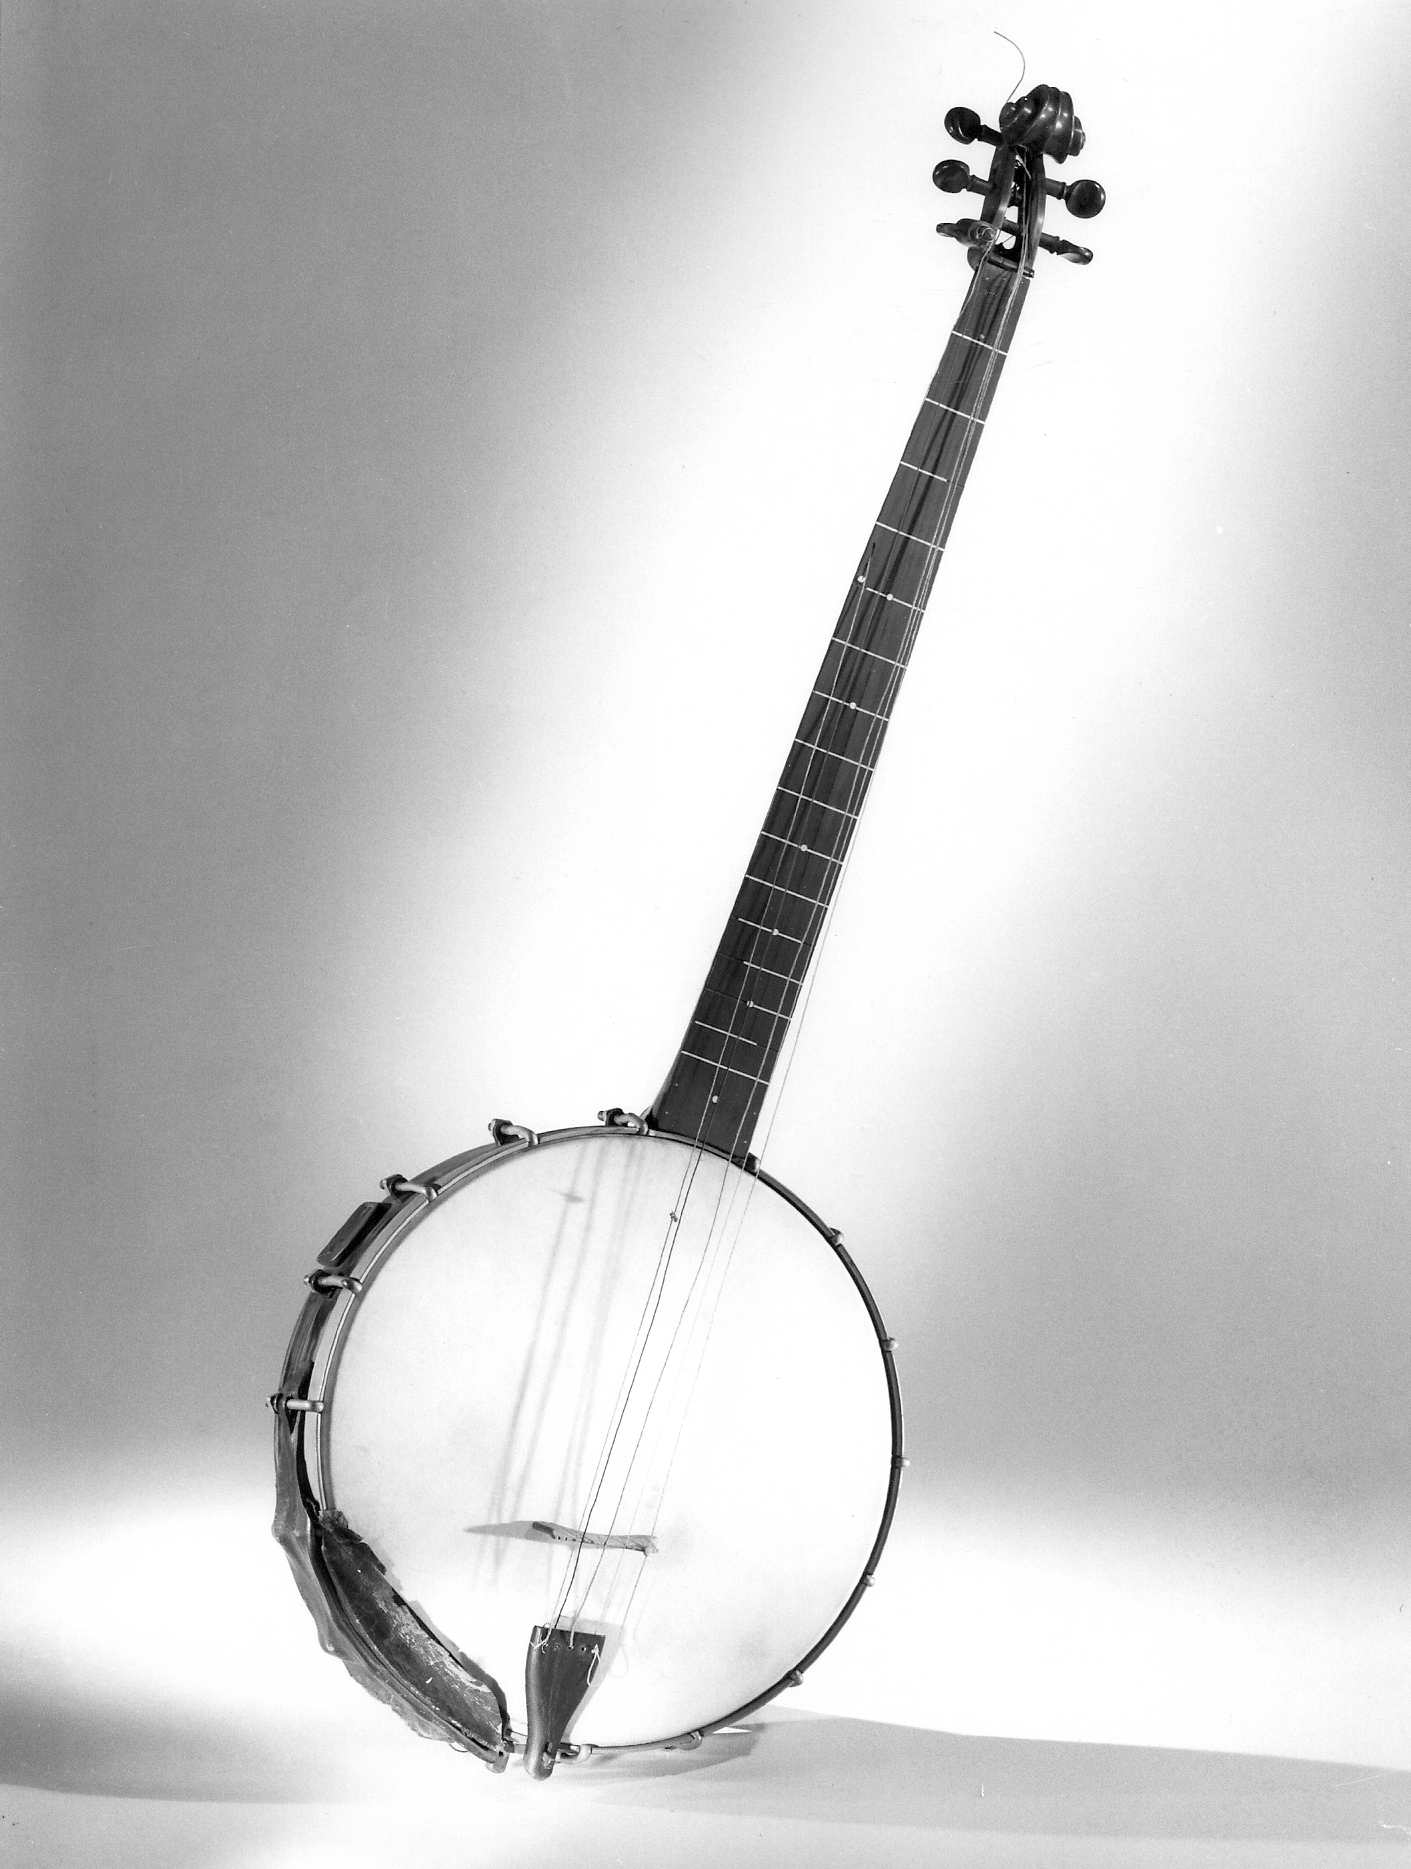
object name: banjo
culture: american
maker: hercules mccord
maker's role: maker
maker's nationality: american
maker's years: 1855-1890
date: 1859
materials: metal, wood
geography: united states